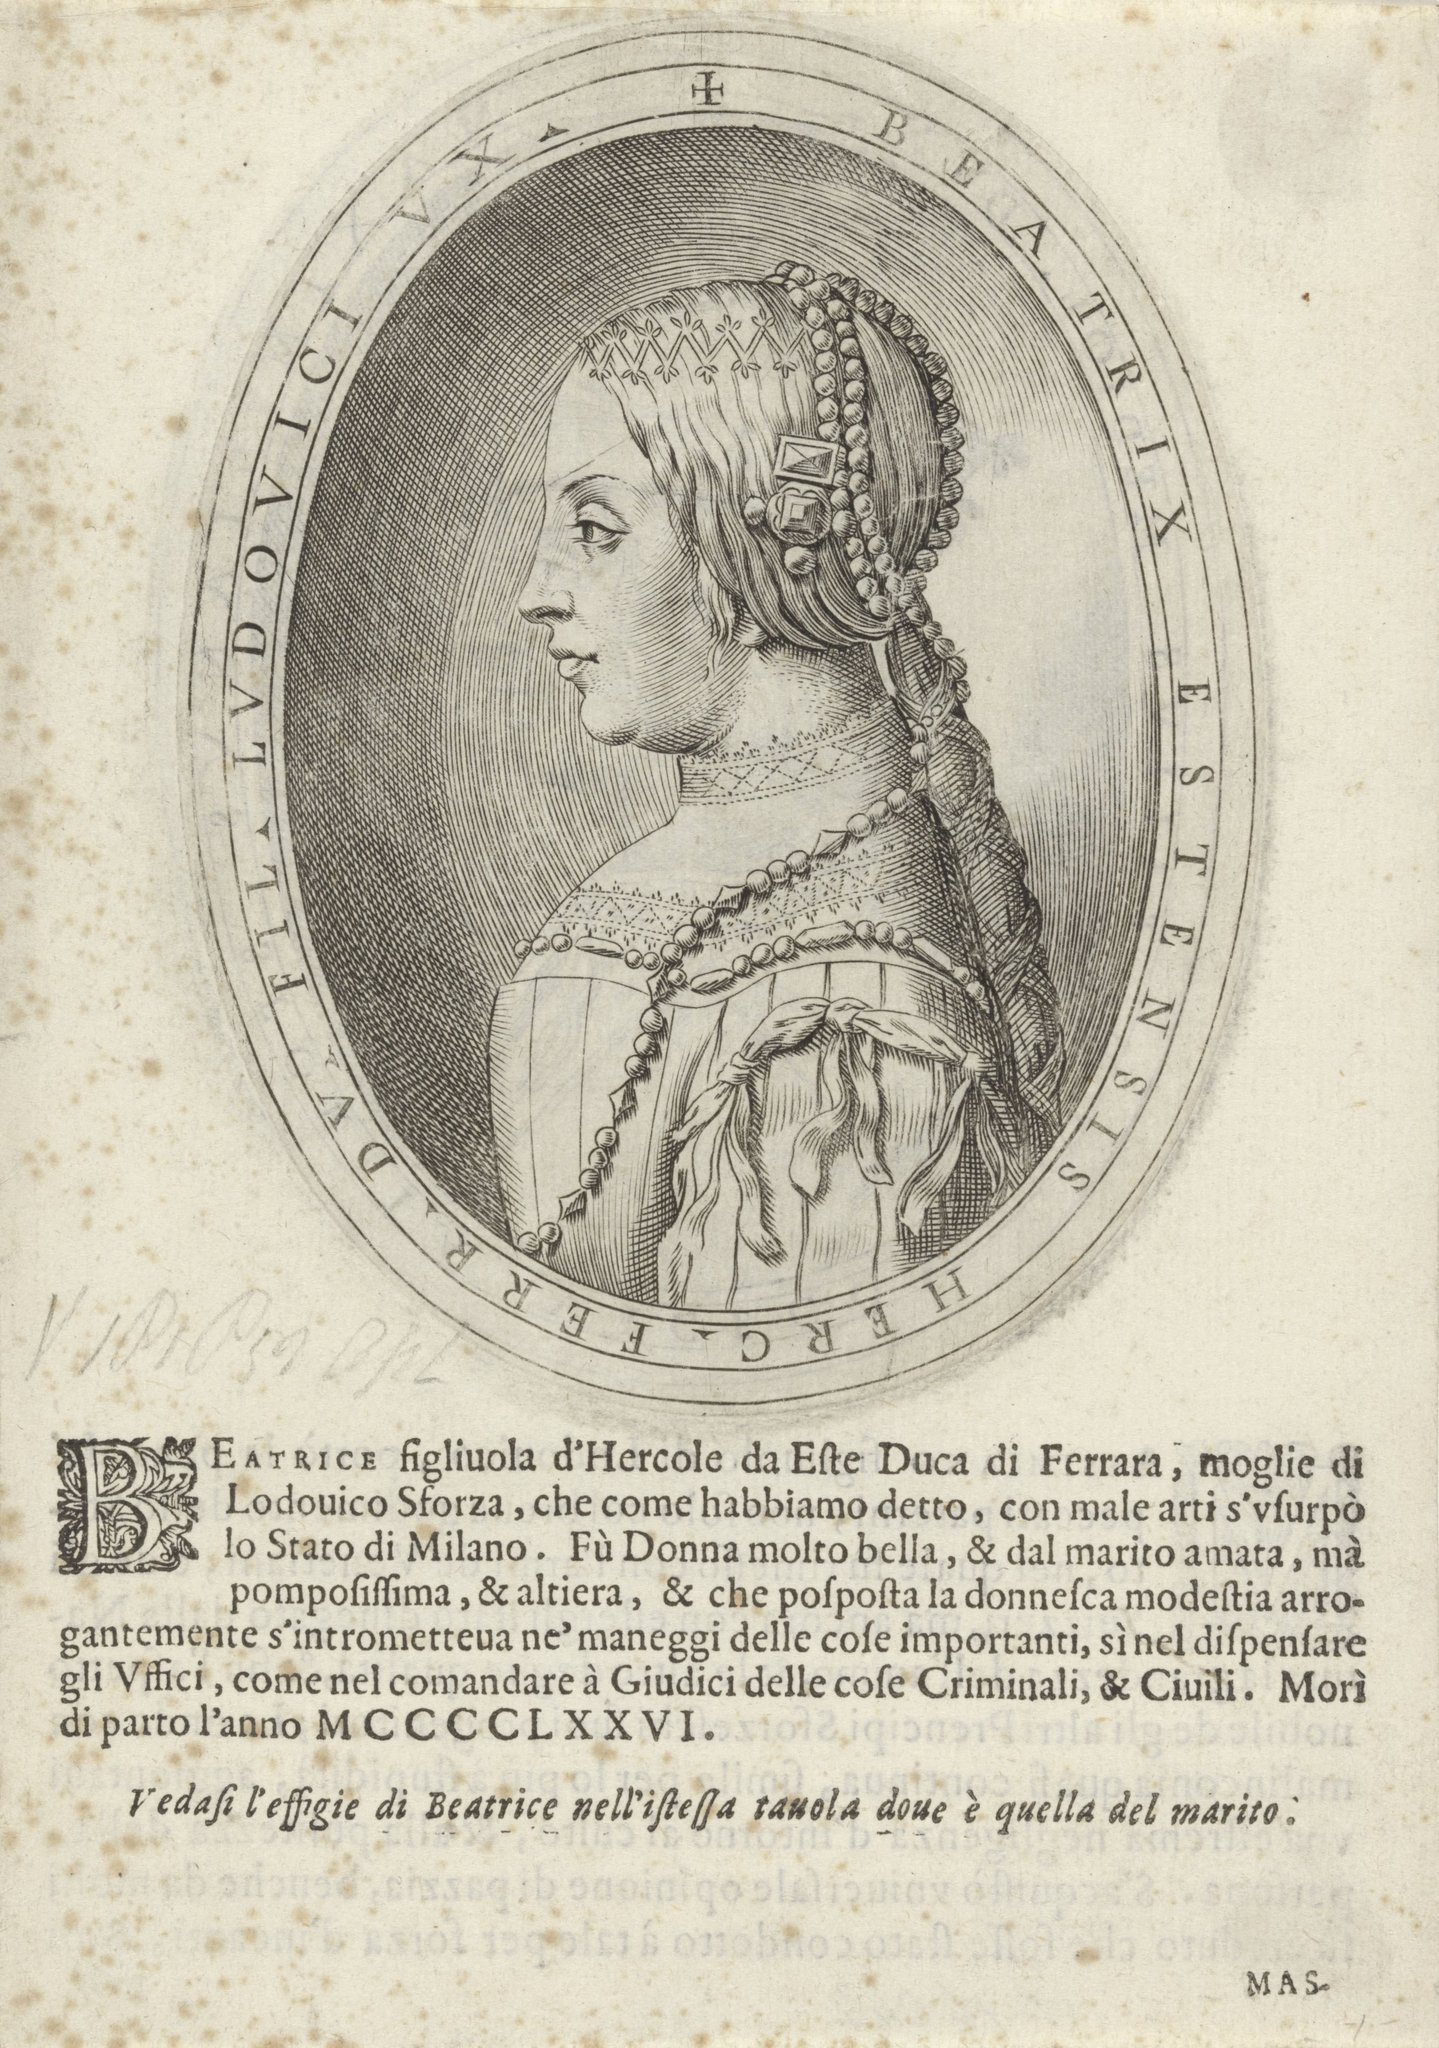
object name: book illustration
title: Portret van Beatrice d'Este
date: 1585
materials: paper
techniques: engraving, letterpress printing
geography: italy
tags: historical persons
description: Een getekende voorstudie door Antonio Campi wordt bewaard in het British Museum te Londen. Prent uit Antonio Campo, Cremona fedelissima citta, et nobilissima colonia de Romani rappresentata in disegno col suo contado; et illustrata d'una breve historia, Milaan: Filippo Ghisolfi 1642, vol. 4, p. 103.